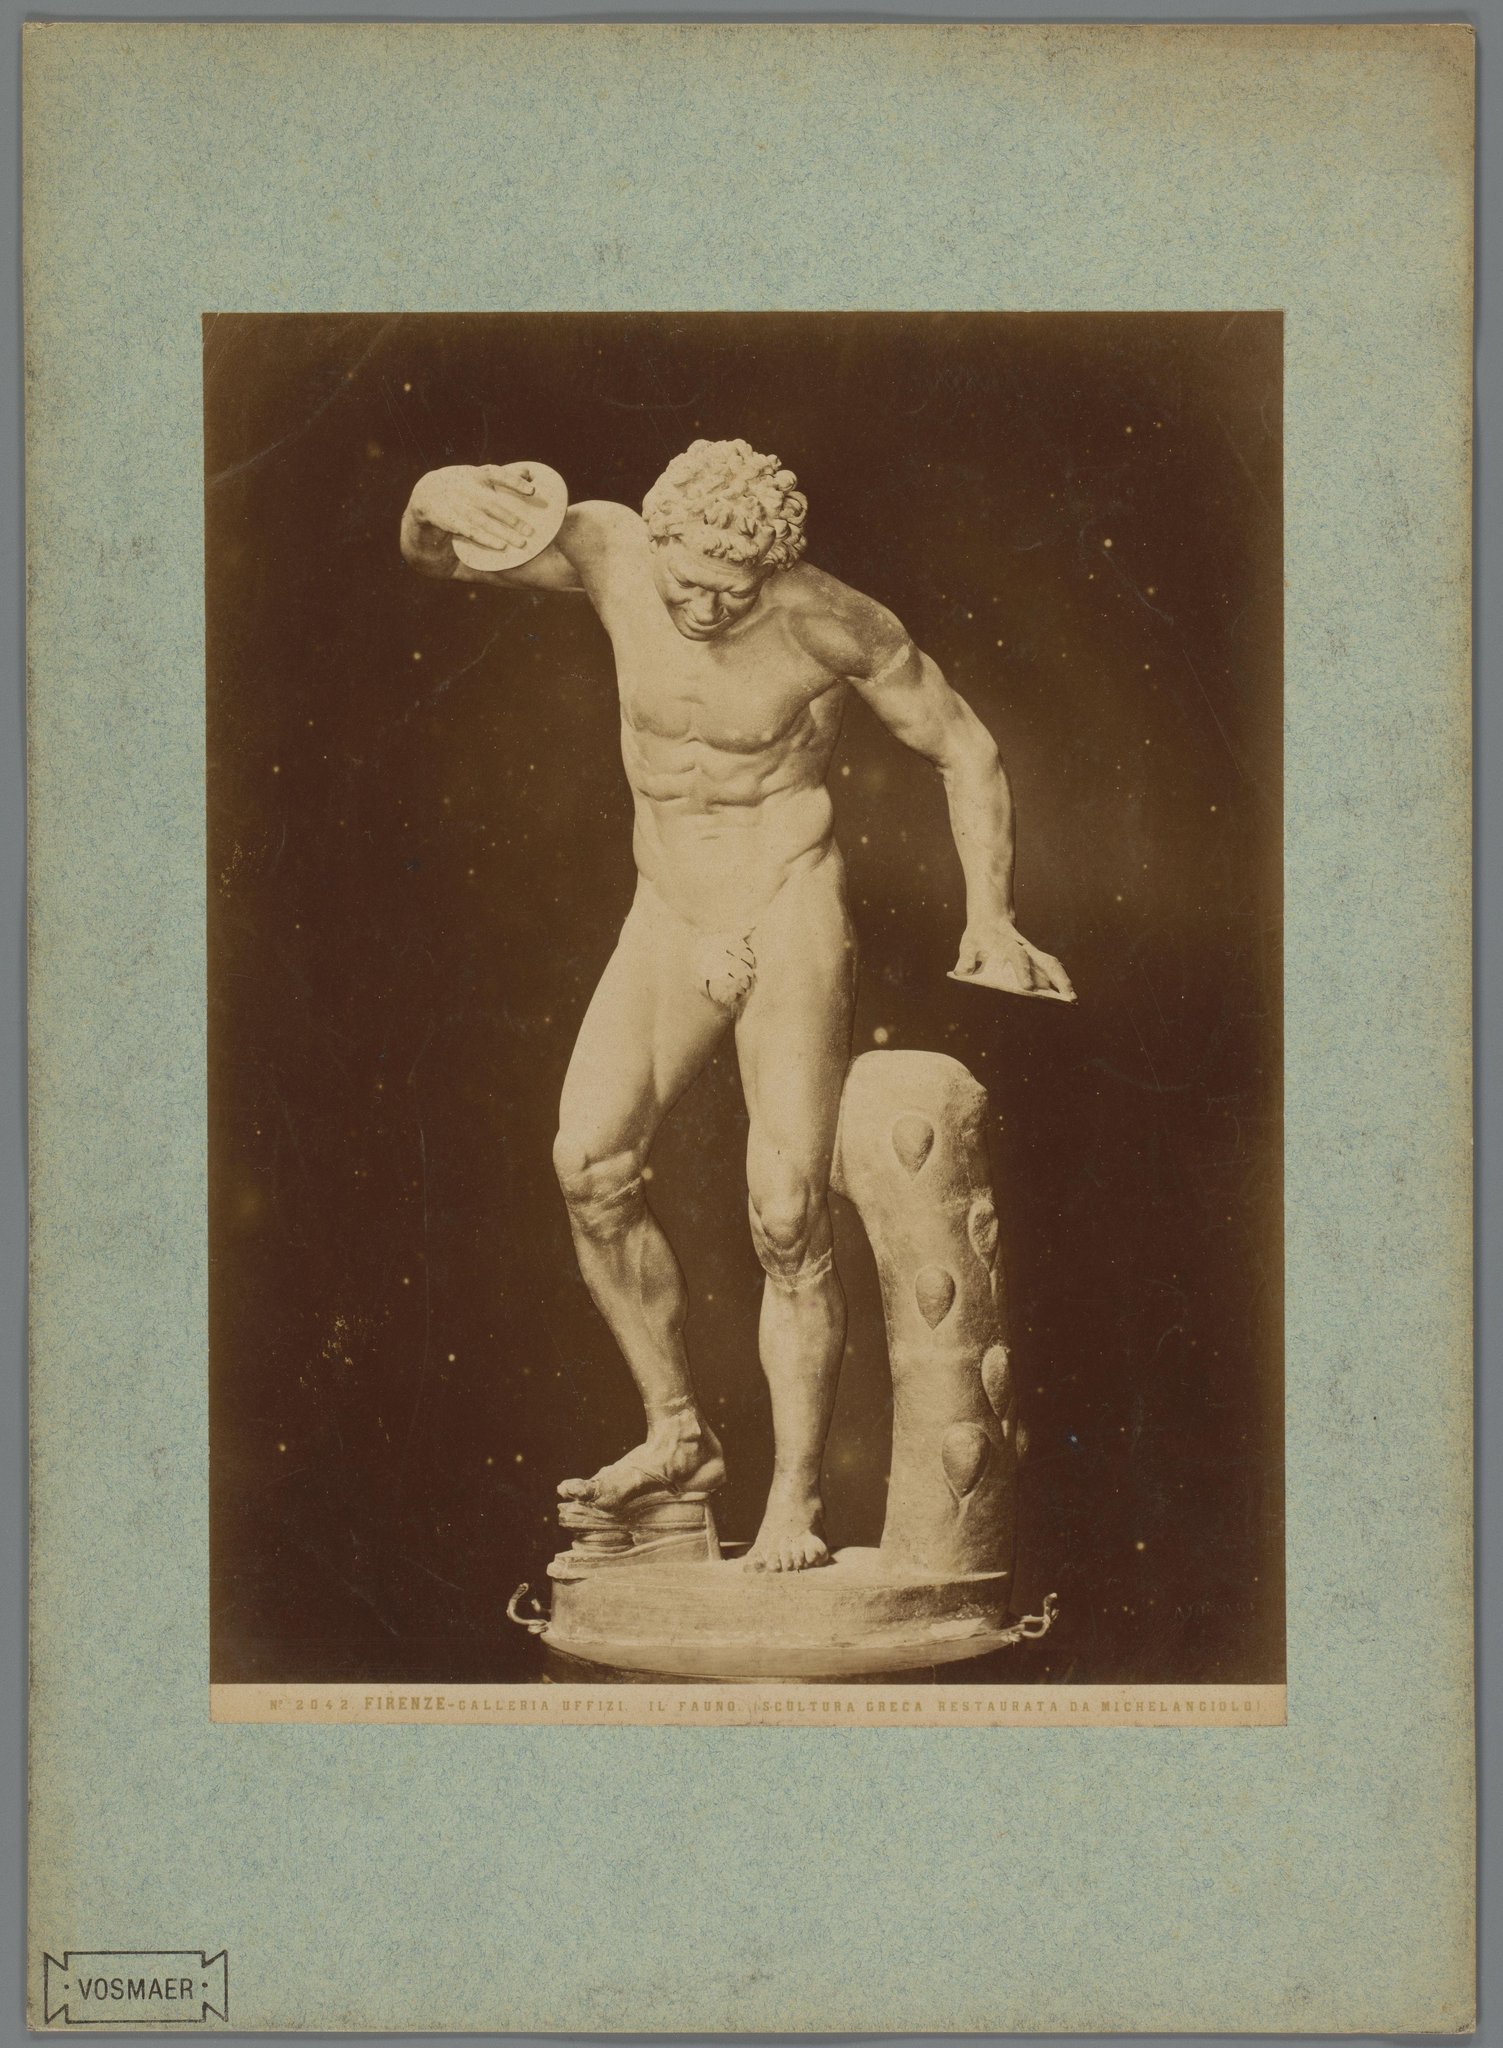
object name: photograph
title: Il fauno (scultura greca restaurata da Michelangiolo)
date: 1852-1900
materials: cardboard, paper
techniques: albumen print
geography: florence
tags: satyrs, fauns, sileni, piece of sculpture, reproduction of a piece of sculpture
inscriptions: collector's mark: ‘VOSMAER’, inscription: ‘doubl’, number: ‘No. 2042.’